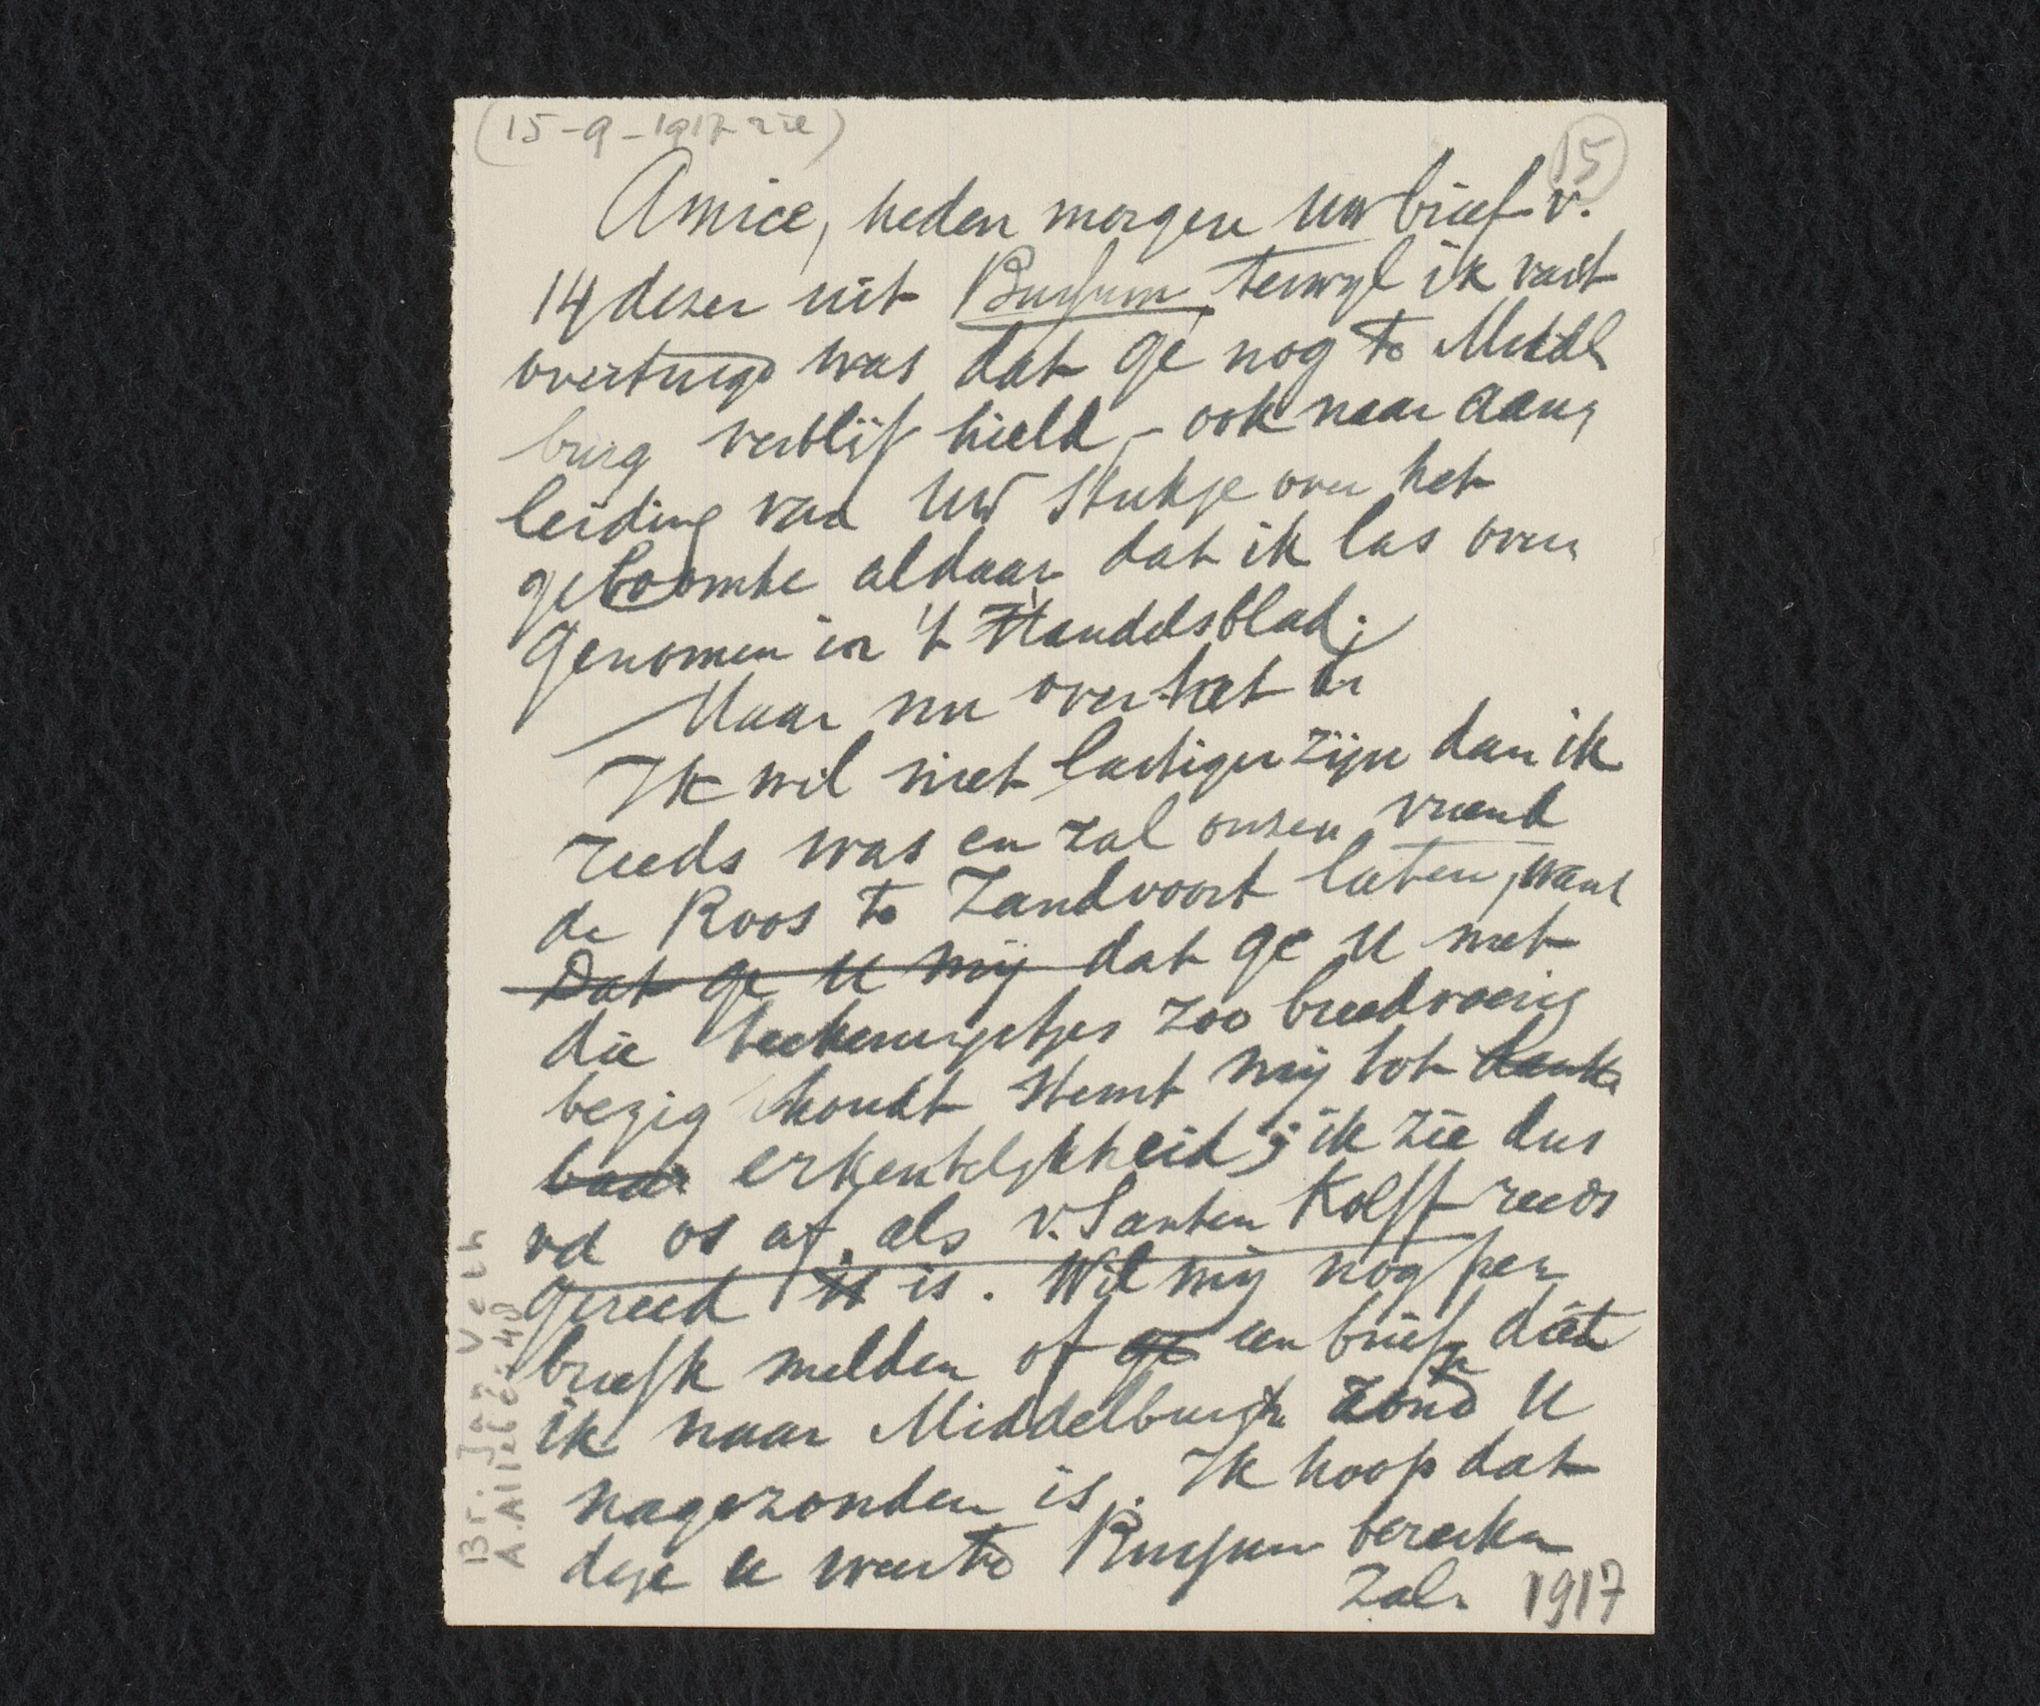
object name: letter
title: Brief aan Jan Veth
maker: august allebé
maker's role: draughtsman, print maker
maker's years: 1838-1927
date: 1848-1927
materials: ink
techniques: pen, writing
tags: dordrecht, painter, print maker, draughtsman, designer, jan veth, haarlem, sjoerd hendrik de roos, middelburg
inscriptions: collector's mark: ‘RPK’